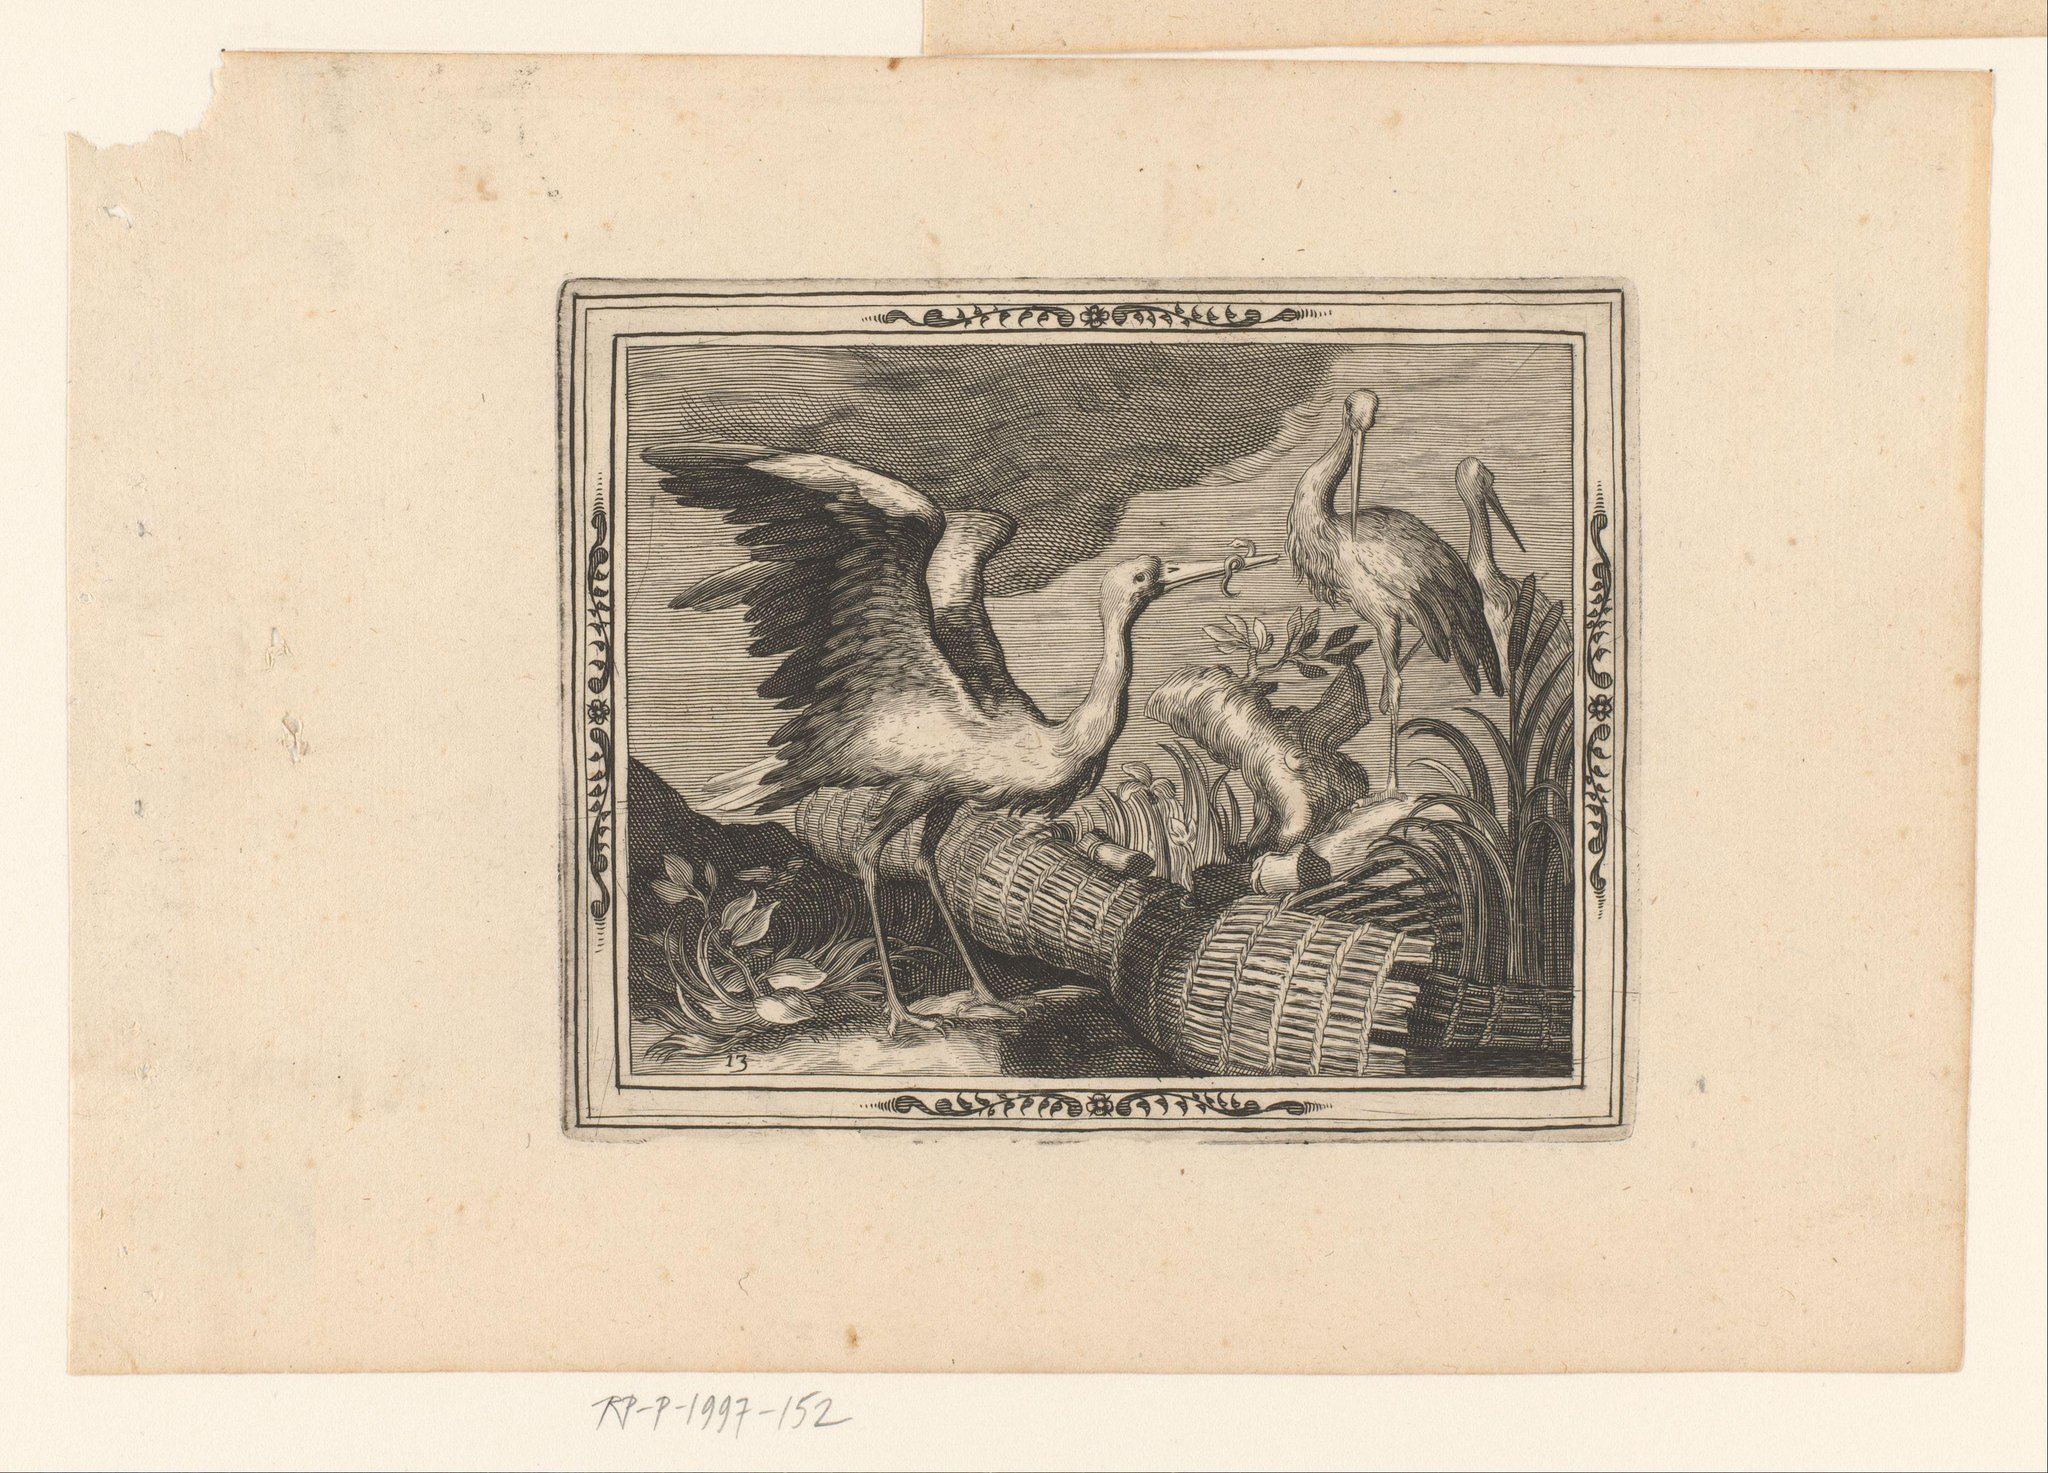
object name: print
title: Diervoorstellingen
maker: jean leclerc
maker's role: print maker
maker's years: 1587-1633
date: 1597-1633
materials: paper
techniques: engraving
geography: france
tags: shore-birds and wading-birds: stork